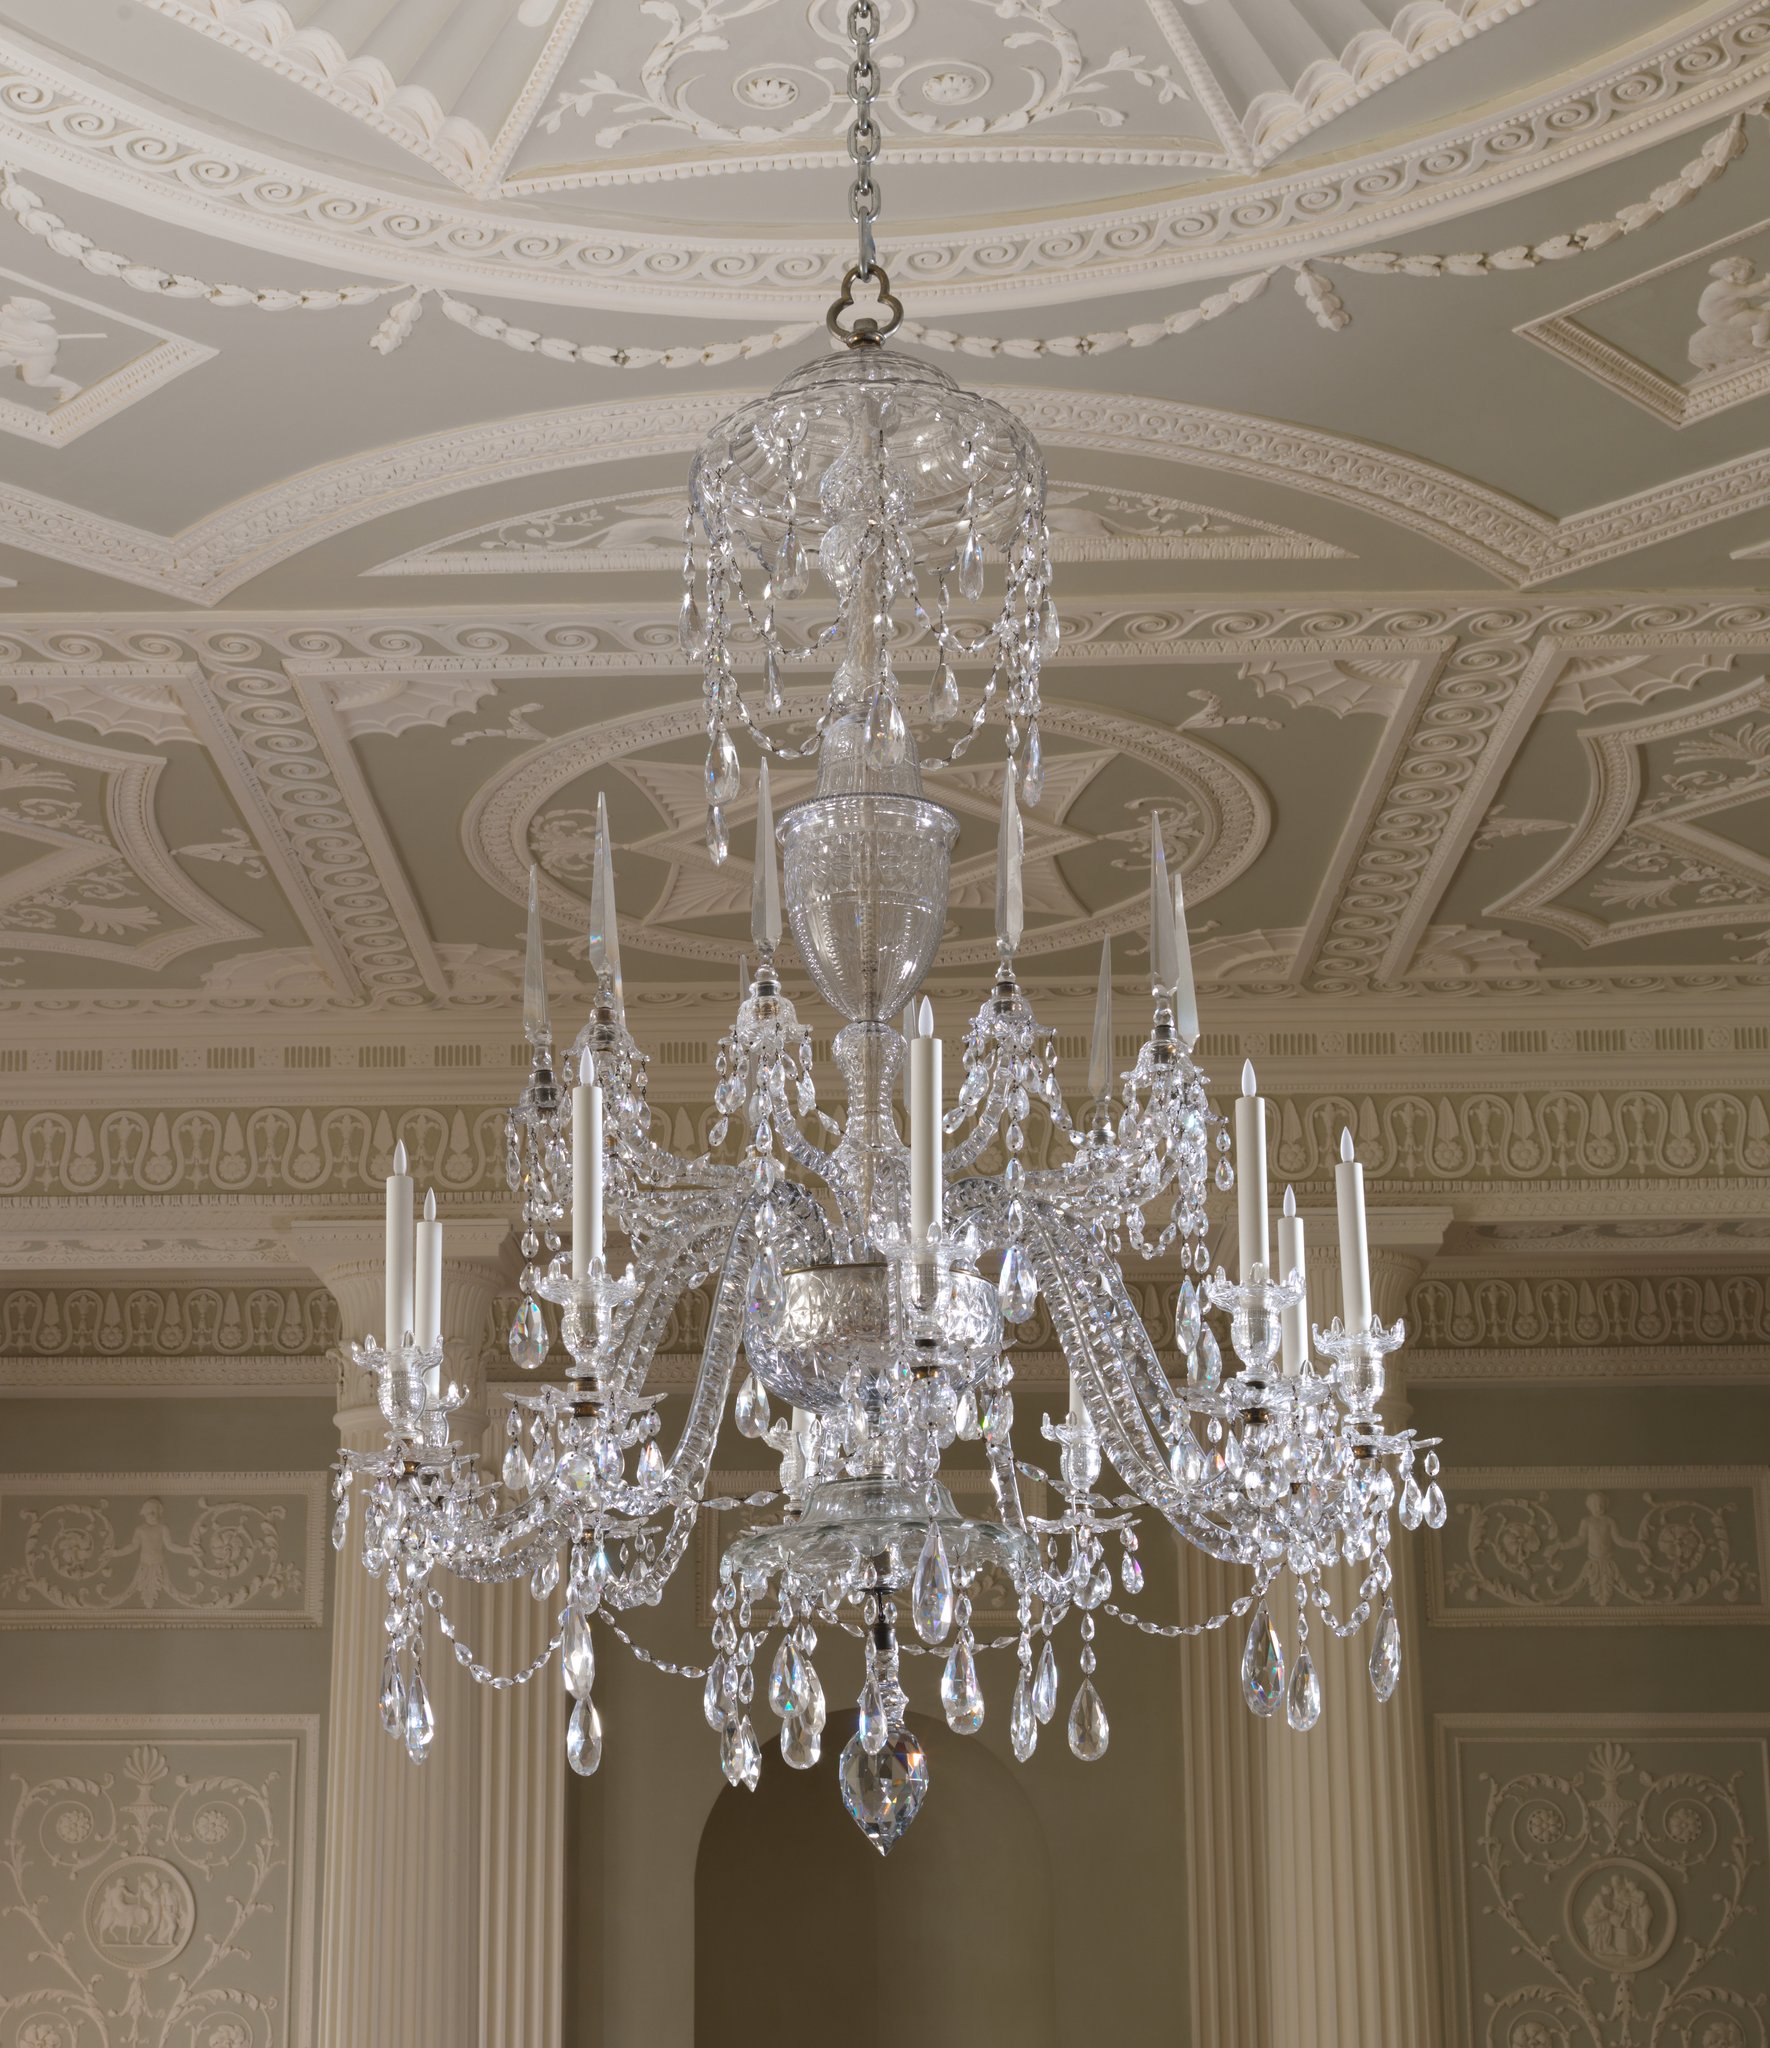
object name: chandelier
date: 1787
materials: glass